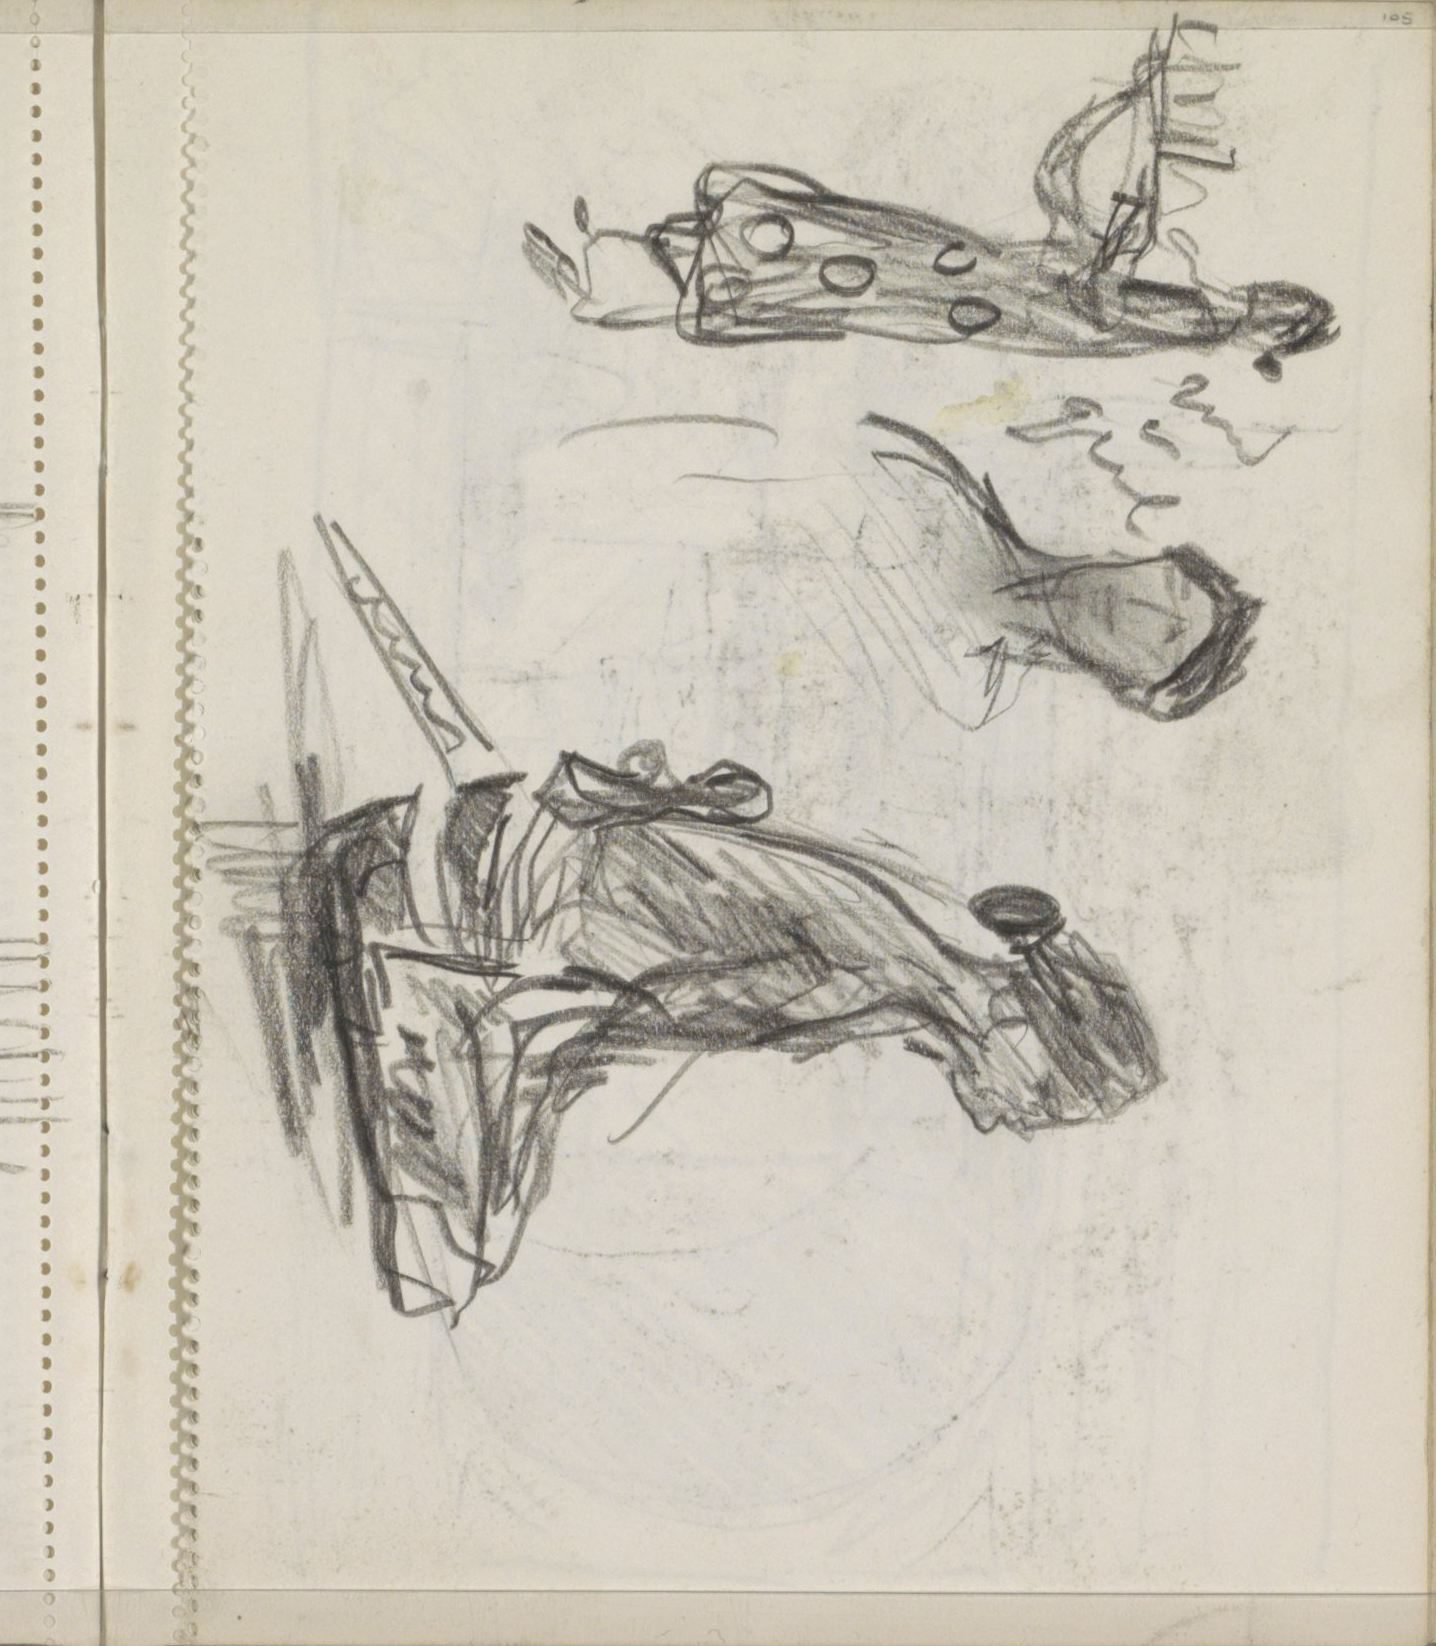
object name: sketchbook leaf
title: Zittende Indonesiër met een zwaard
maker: marius bauer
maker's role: draughtsman, print maker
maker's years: 1867-1932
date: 1925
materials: chalk, paper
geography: indonesia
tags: asiatic races and peoples, head (human), sitting figure, carrying something, hacking and thrusting weapons: sword, folk costume, regional costume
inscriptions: kleurnotitie, handgeschreven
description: Tevens studies van een mannenkop en een figuur met een schaal in de handen. Pagina 105 uit een schetsboek met 67 bladen.